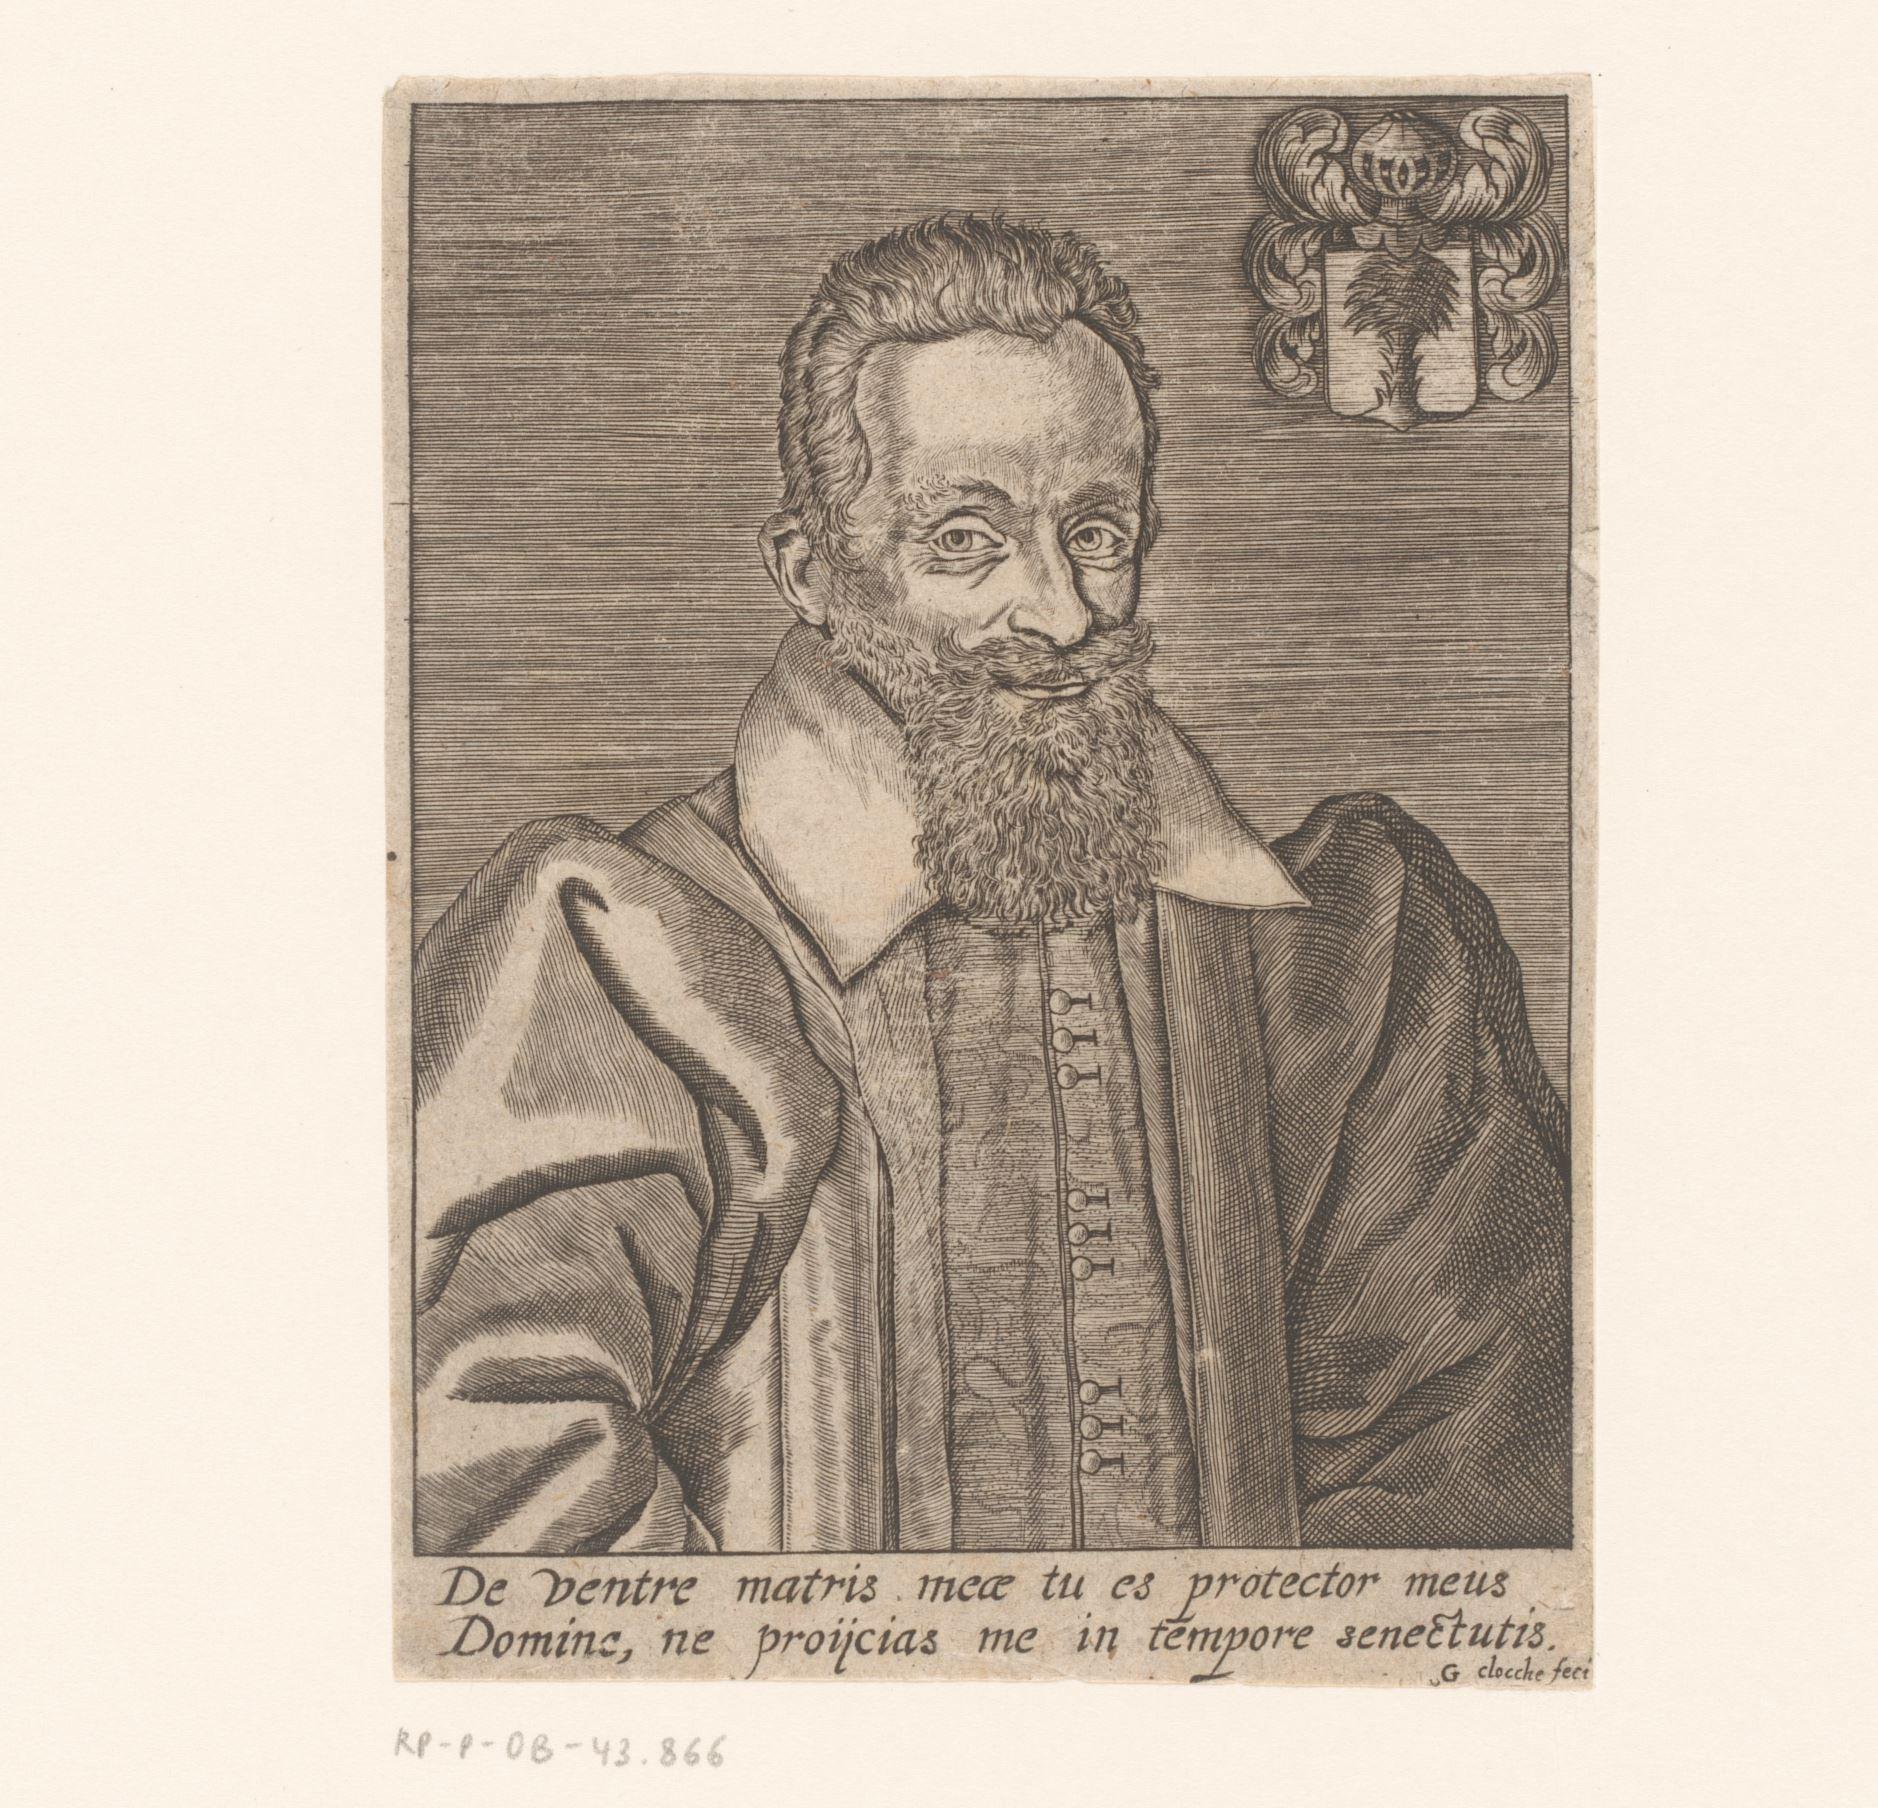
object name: book illustration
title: Man met baard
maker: claude de la cloche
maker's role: print maker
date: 1600-1699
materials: paper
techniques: engraving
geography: france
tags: adult man, armorial bearing, heraldry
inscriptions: collector's mark: Lugt 2228